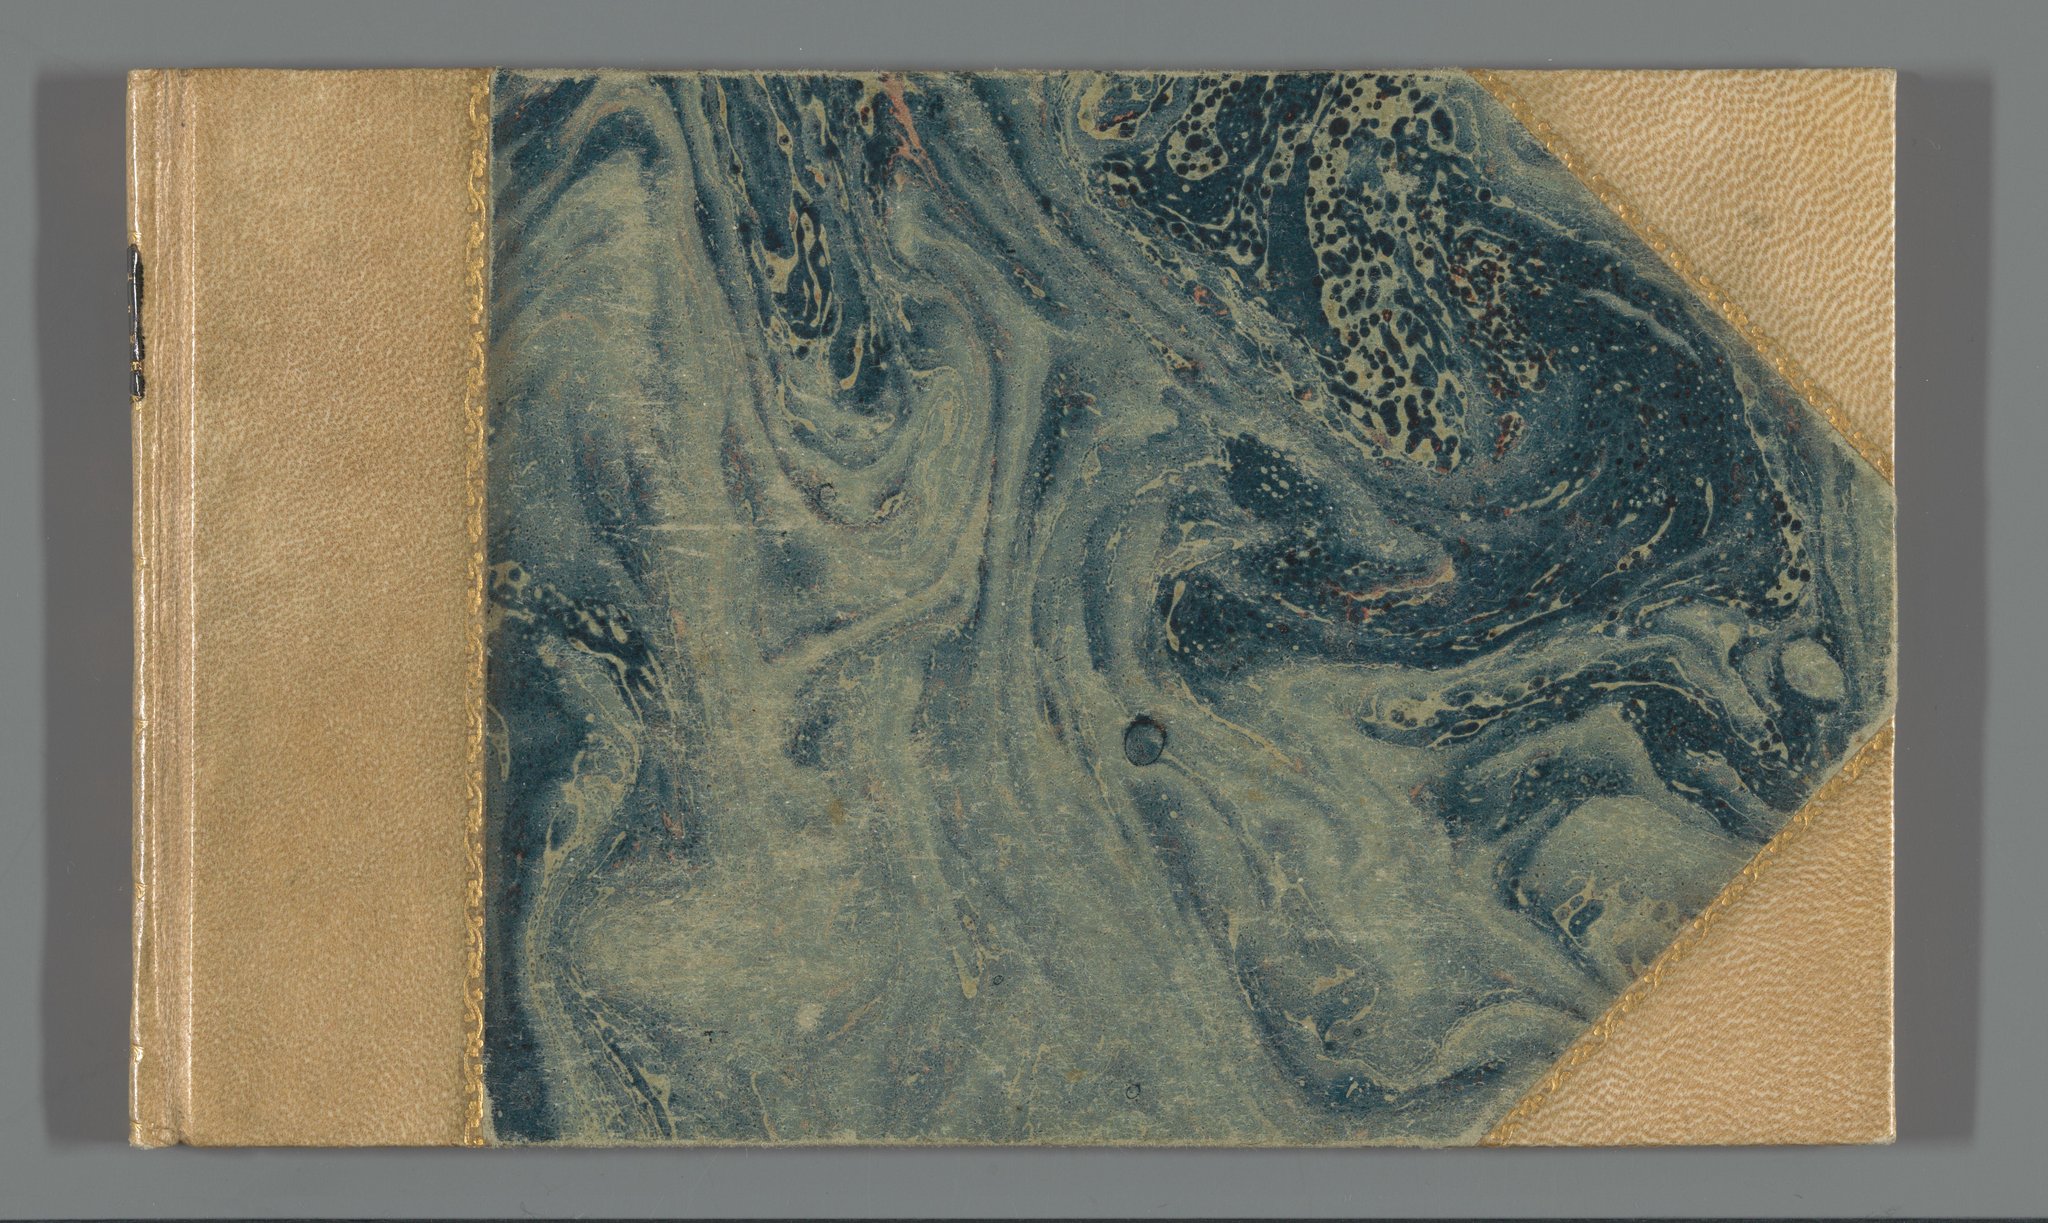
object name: prentrecueil, prentenalbum, prentalbum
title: Venationes Marcus Geerart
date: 1570-1612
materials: gold leaf, paper, parchment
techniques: bookbinding, printing, engraving, marbling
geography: antwerp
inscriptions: bookplate: ‘EX LIBRIS SCHWERDTII’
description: Album met een serie jachtscènes bestaande uit negen prenten. Album uit de jachtbibliotheek van Carl Franz Georg Richard Schwerdt. Perkamenten band, versierd met gemarmerd papier, met voorin twee blanco bladen en achterin drie blanco bladen.